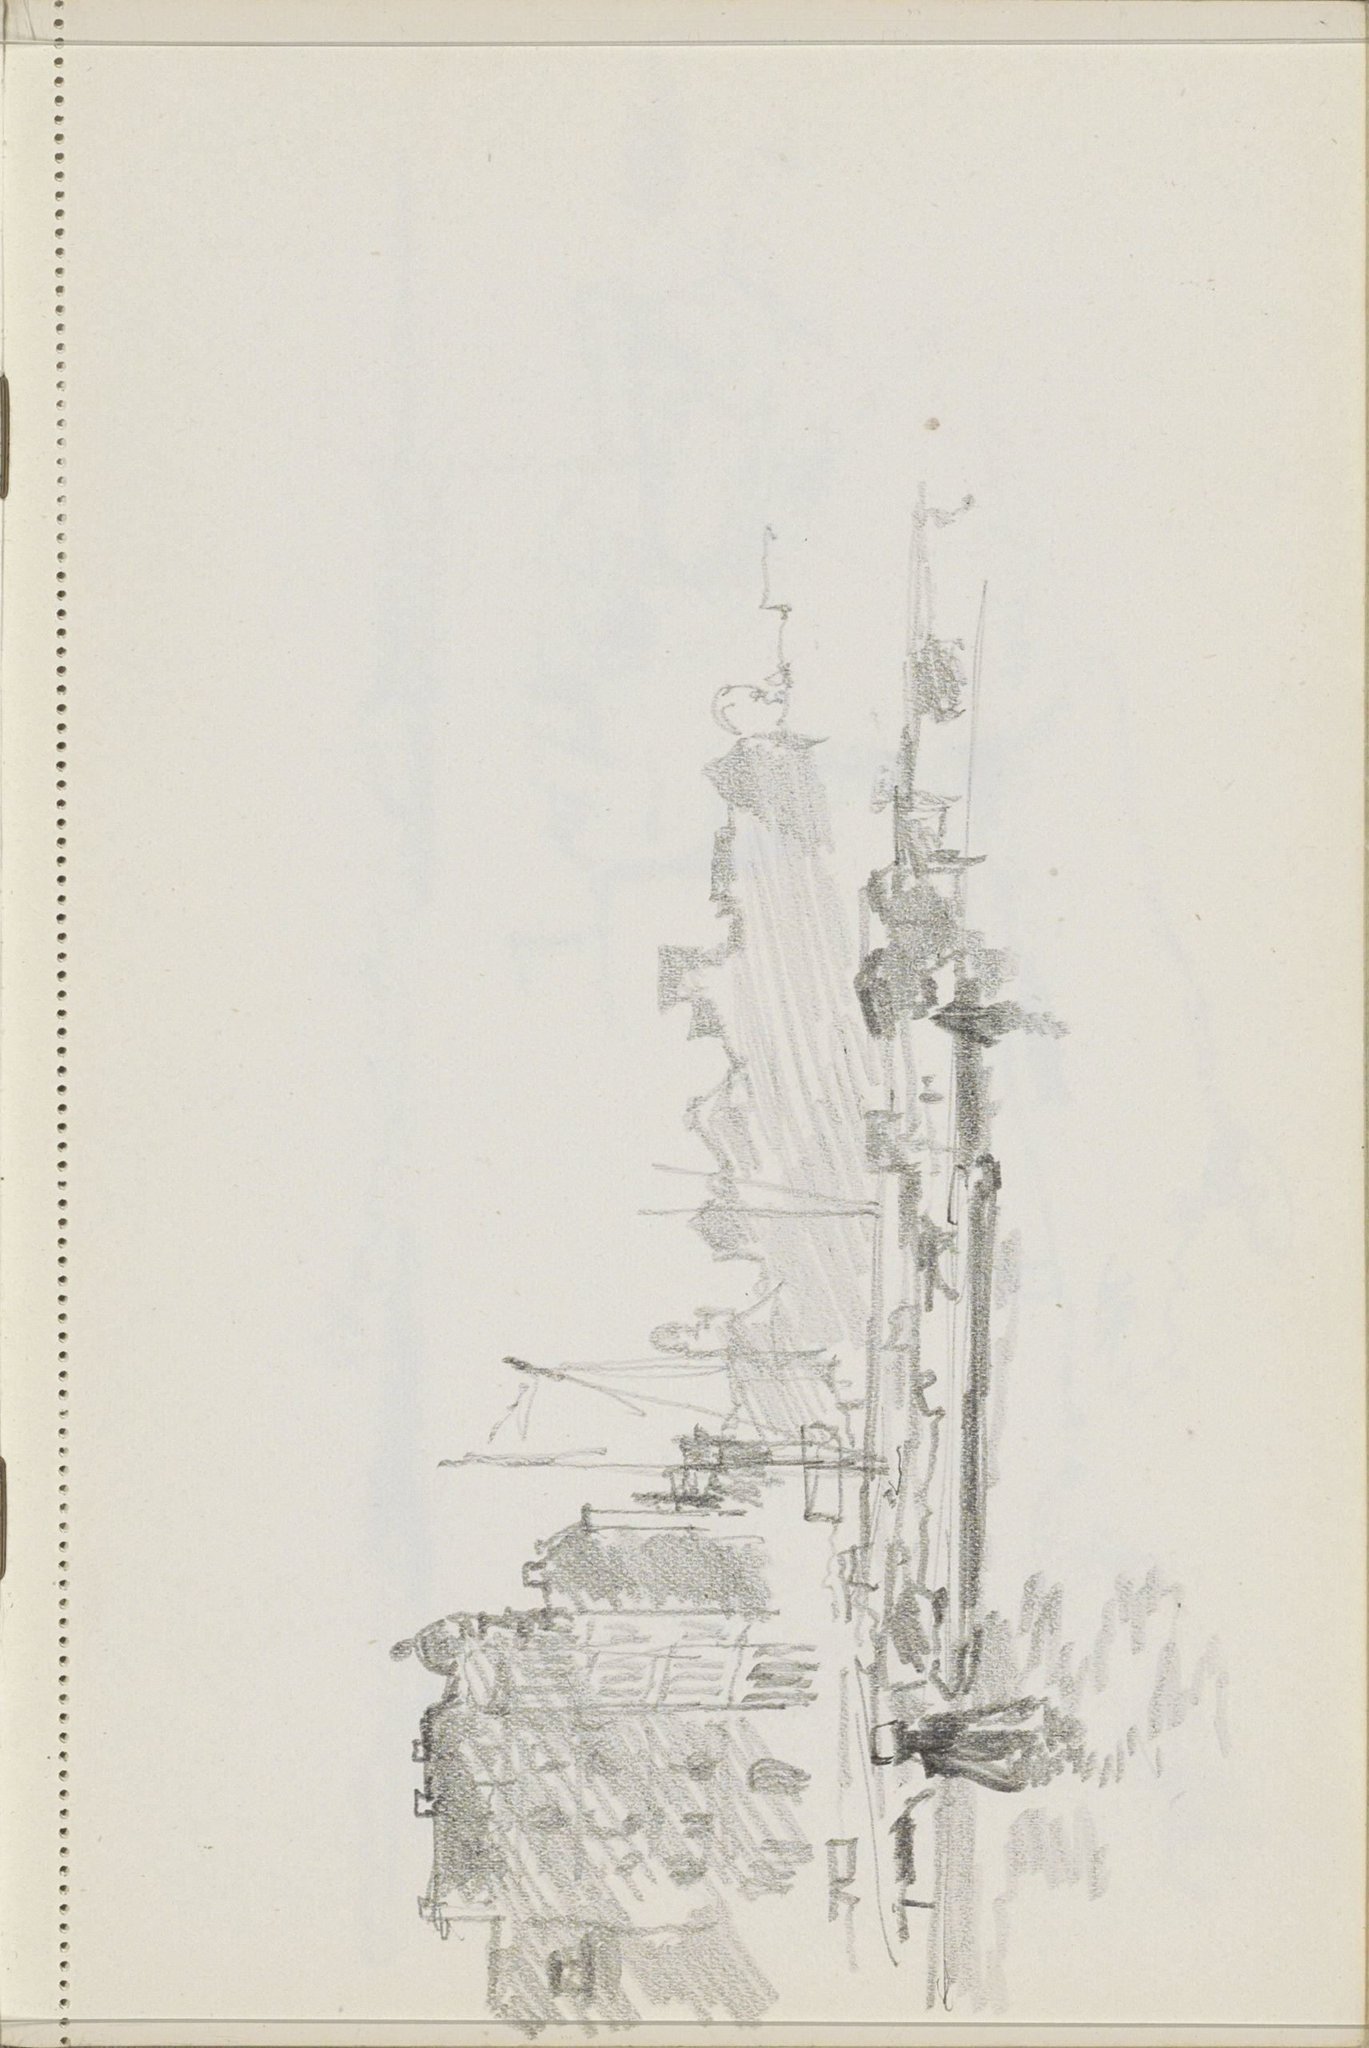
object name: sketchbook leaf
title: Stadsgezicht te Amsterdam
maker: cornelis vreedenburgh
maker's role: draughtsman, print maker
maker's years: 1880-1946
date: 1890-1946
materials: paper, pencil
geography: amsterdam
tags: city-view, and landscape with man-made constructions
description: Blad 52 recto uit een schetsboek met uit 75 bladen.